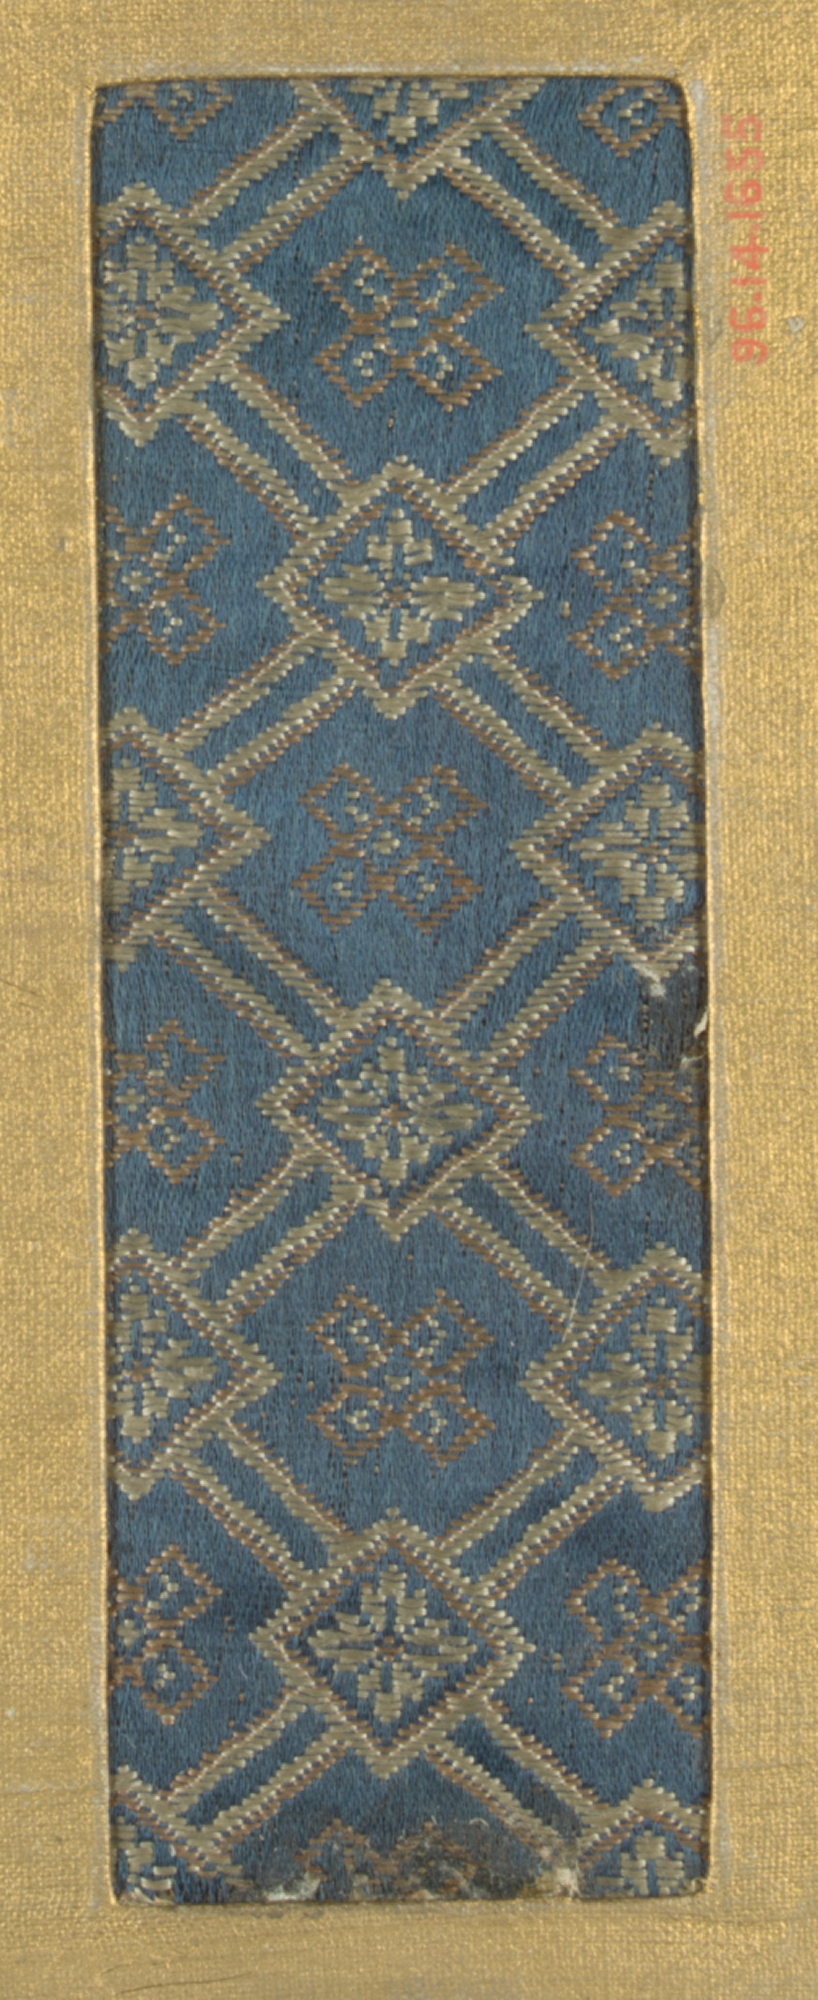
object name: piece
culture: japanese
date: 1701-1900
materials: silk